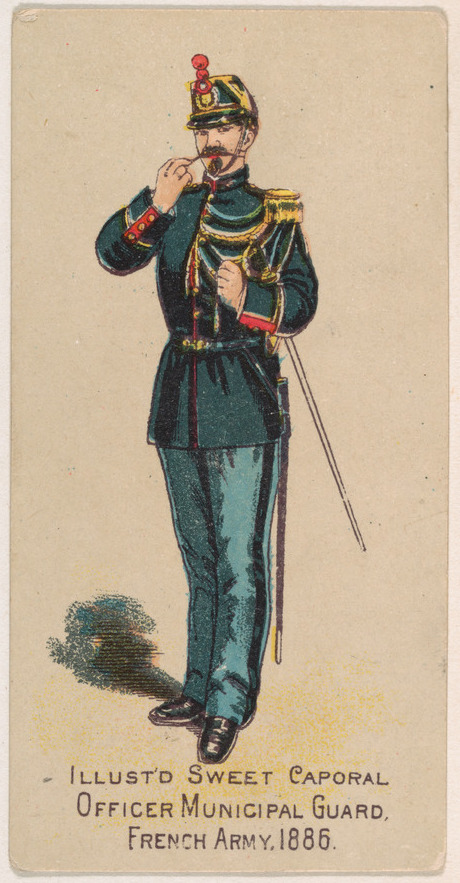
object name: print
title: Officer, Municipal Guard, French Army, 1886, from the Military Series (N224) issued by Kinney Tobacco Company to promote Sweet Caporal Cigarettes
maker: kinney brothers tobacco company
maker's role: publisher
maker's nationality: american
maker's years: 1869-2011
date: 1888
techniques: color lithograph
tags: military,men